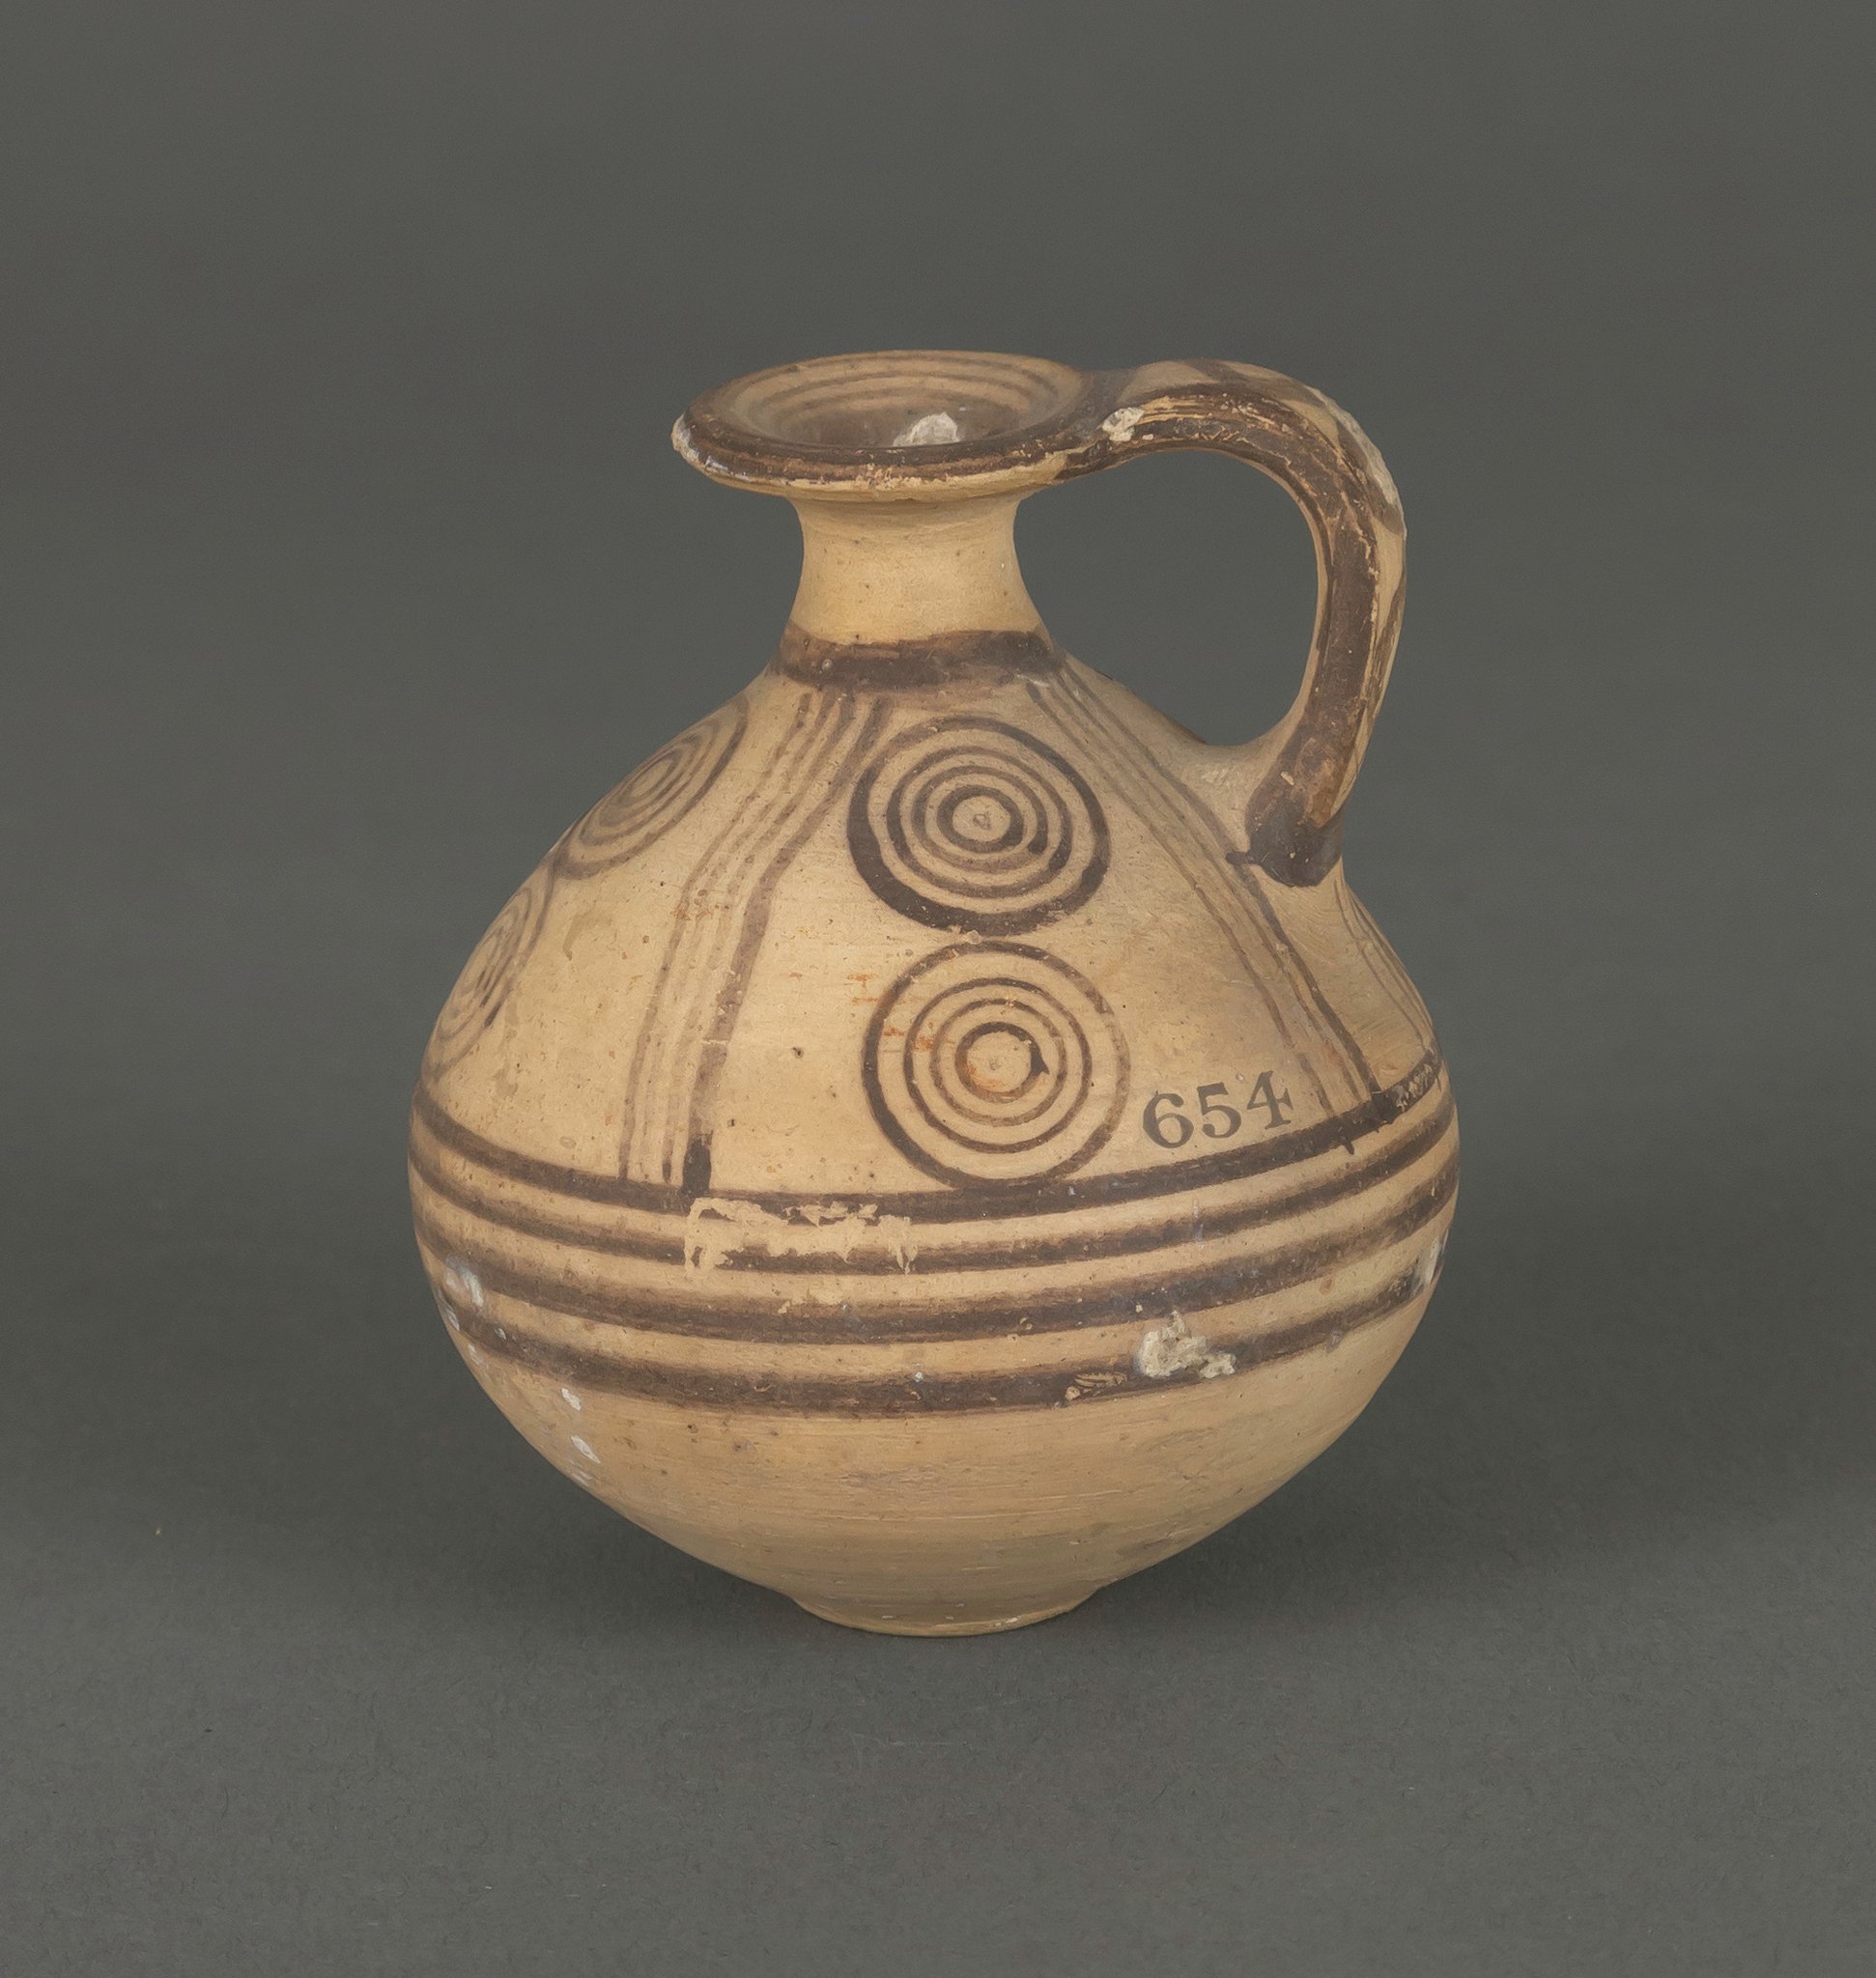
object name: jug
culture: cypriot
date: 1050-900 BCE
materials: terracotta